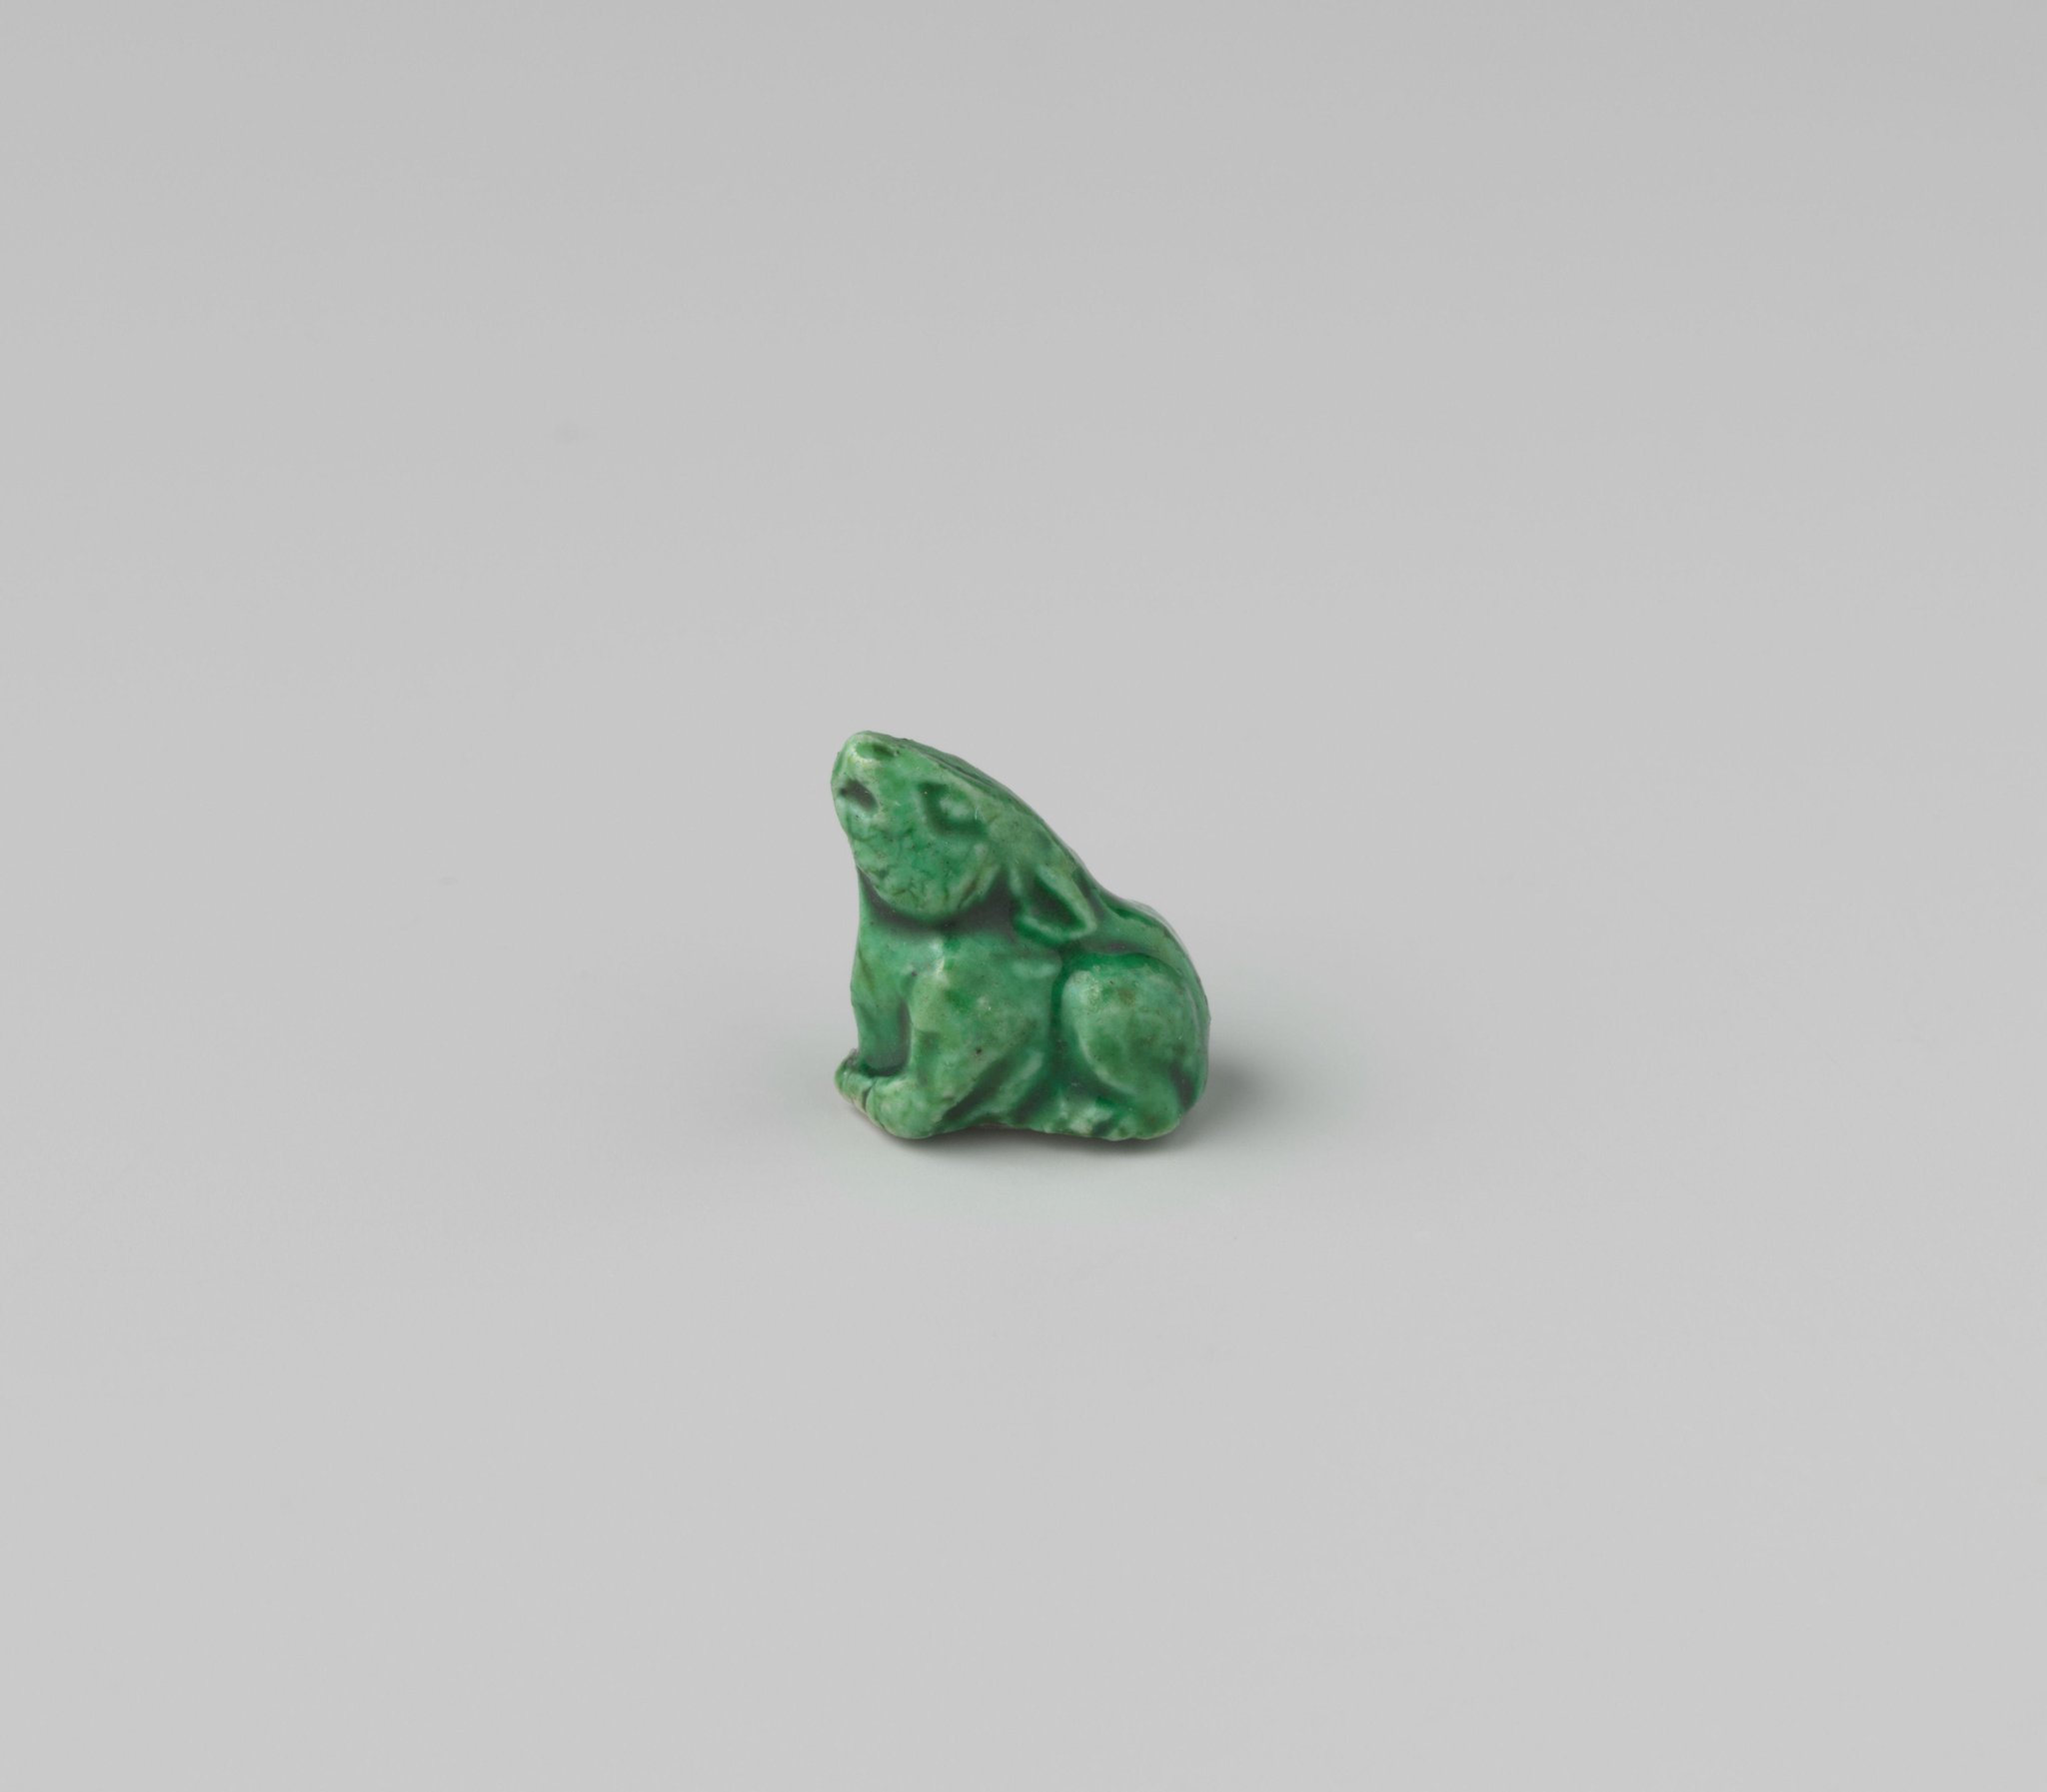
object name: miniature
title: Miniature figure of a hare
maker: Anonymous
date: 1700-1724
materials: paint, porcelain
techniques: firing, forming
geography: china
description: Beeld van porselein van een liggende, omhoog kijkende haas, beschilderd op het biscuit in groen. Email sur biscuit.